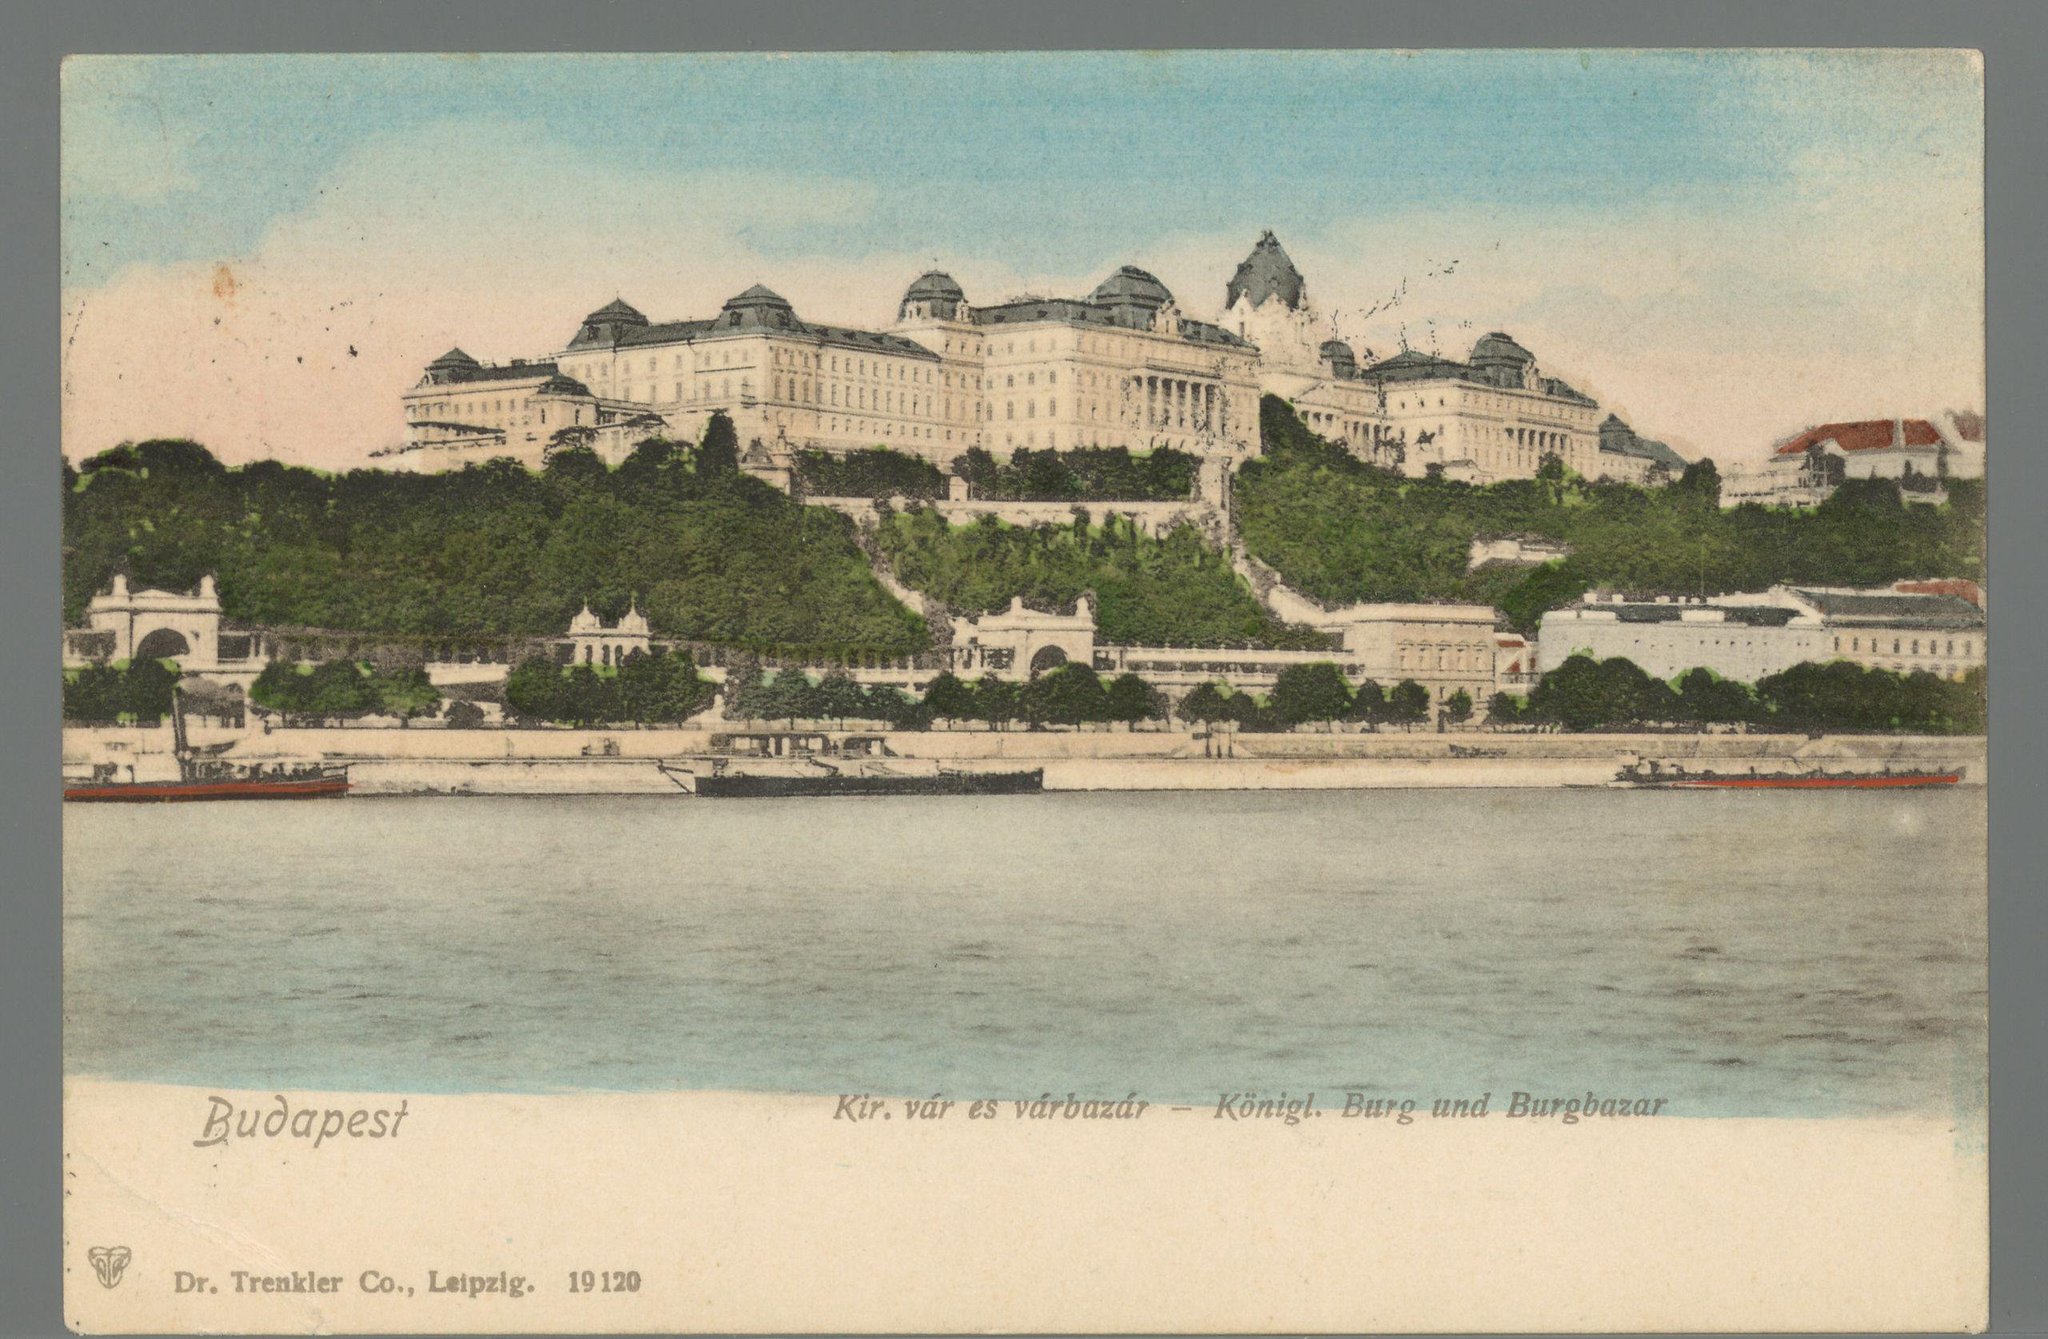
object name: ansichtkaart, prentbriefkaart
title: Budapest - Kir. vár es várbazár / Königl. Burg und Burgbazar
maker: Anonymous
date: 1894-1903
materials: cardboard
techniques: photograph, hand coloring, writing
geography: leipzig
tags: castle, canals, waters (in city)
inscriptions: postage stamp